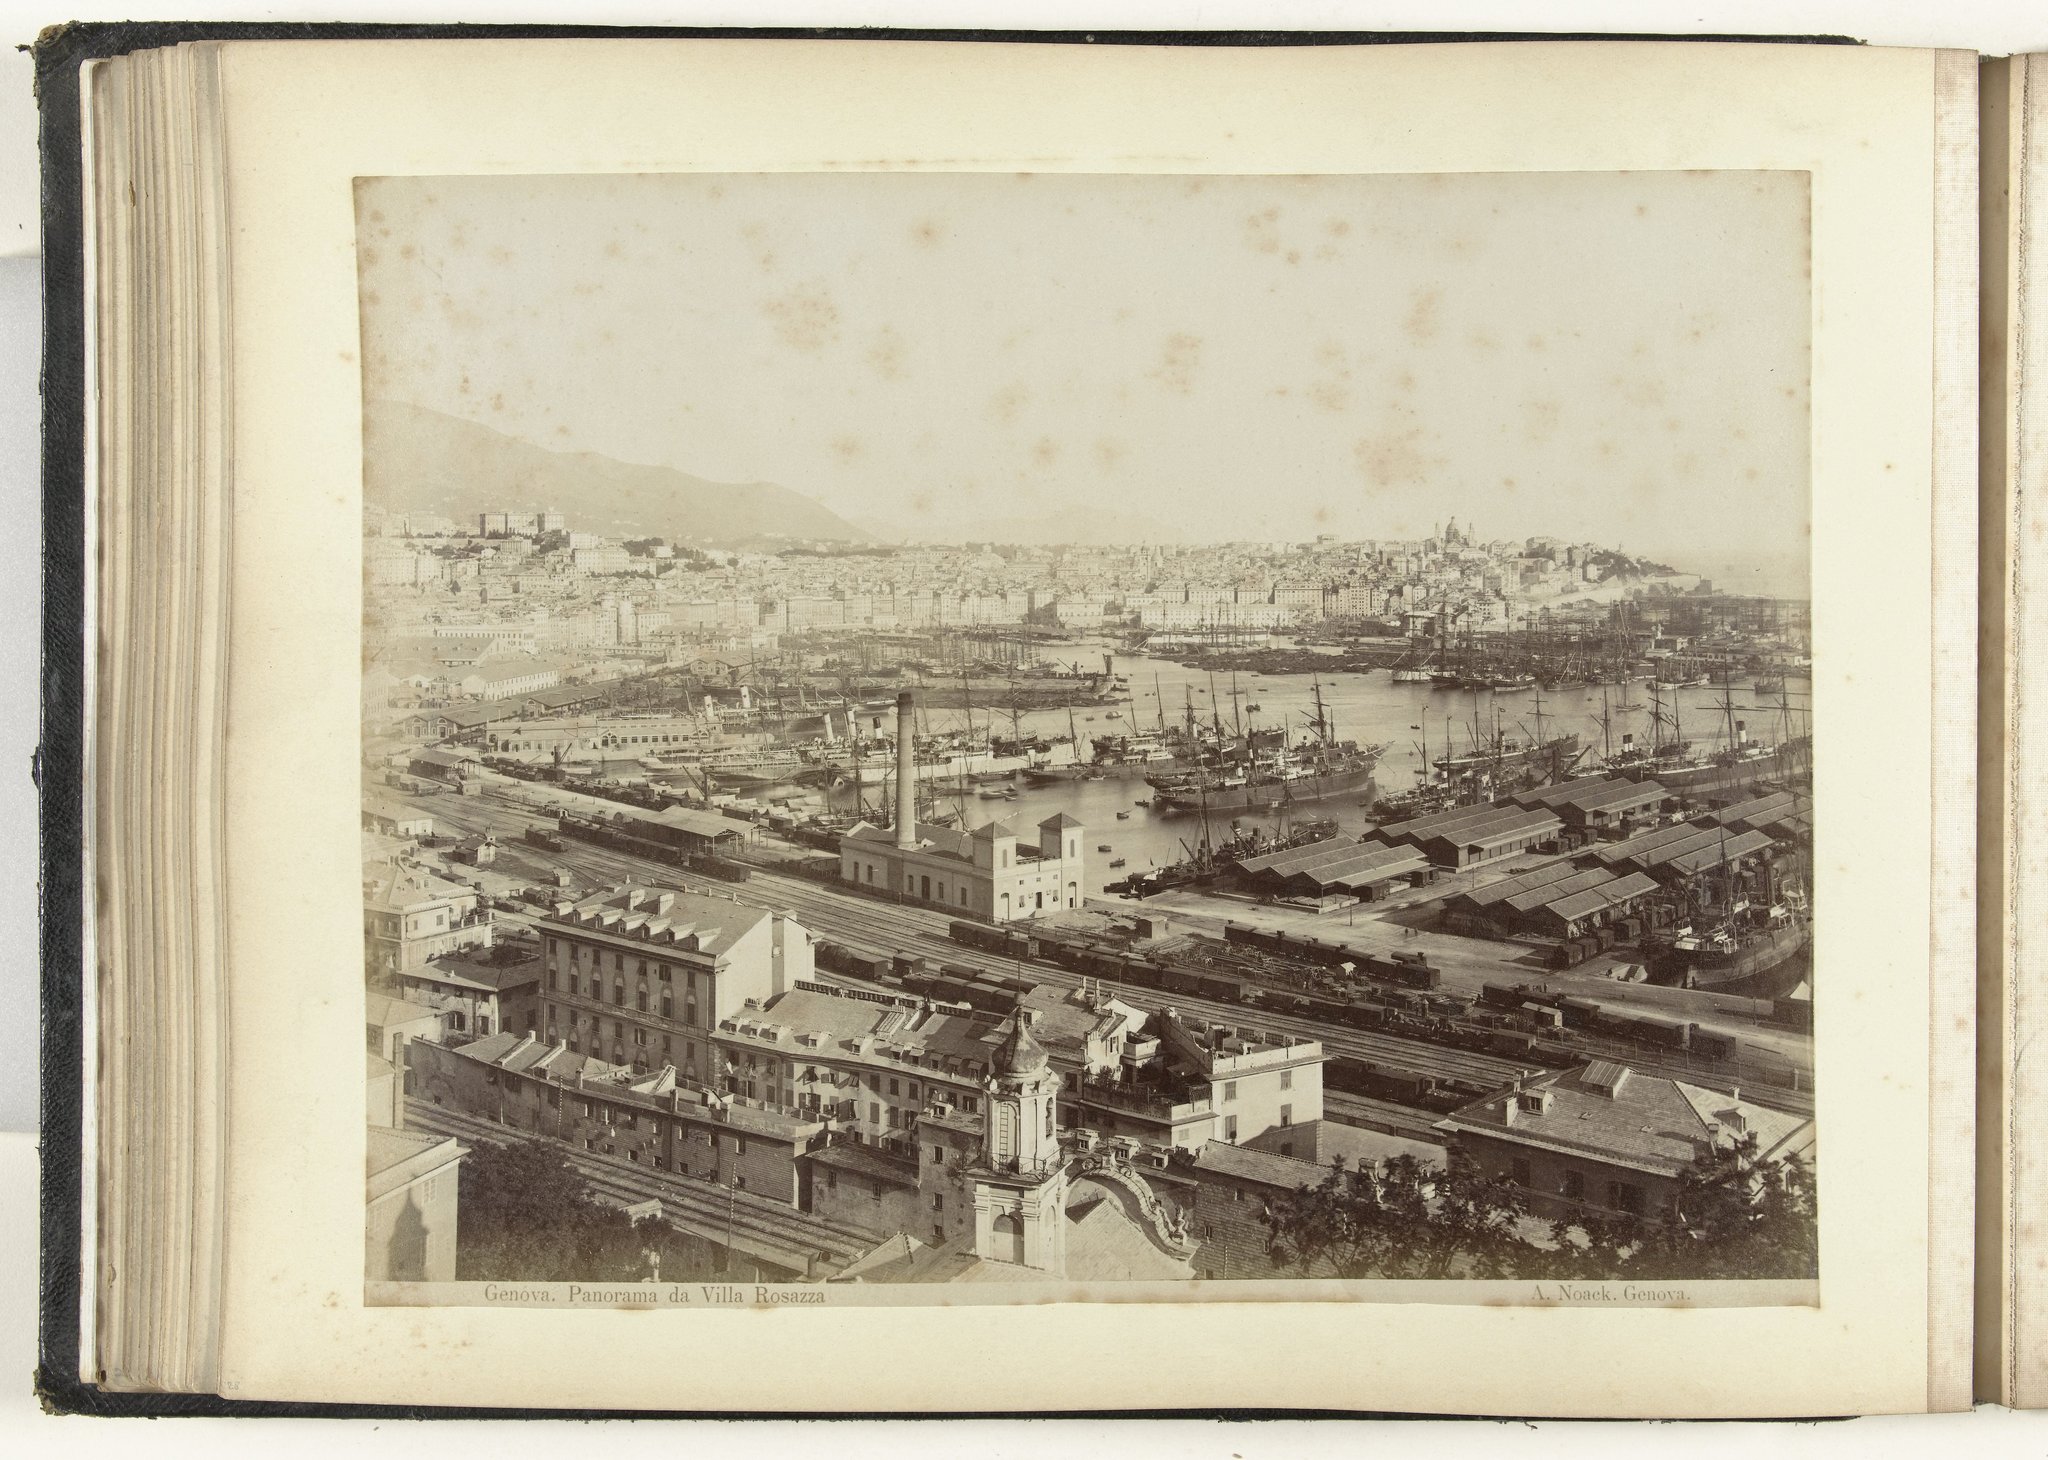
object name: album leaf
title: Gezicht op de industriehaven van Genua, gezien vanaf Villa Rosazza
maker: alfredo noack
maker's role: fotograaf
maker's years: 1833-1895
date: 1858-1893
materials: paper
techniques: albumen print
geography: genoa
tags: harbour, city-view in general; 'veduta'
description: Op de achtergrond is Genua stad zichtbaar.